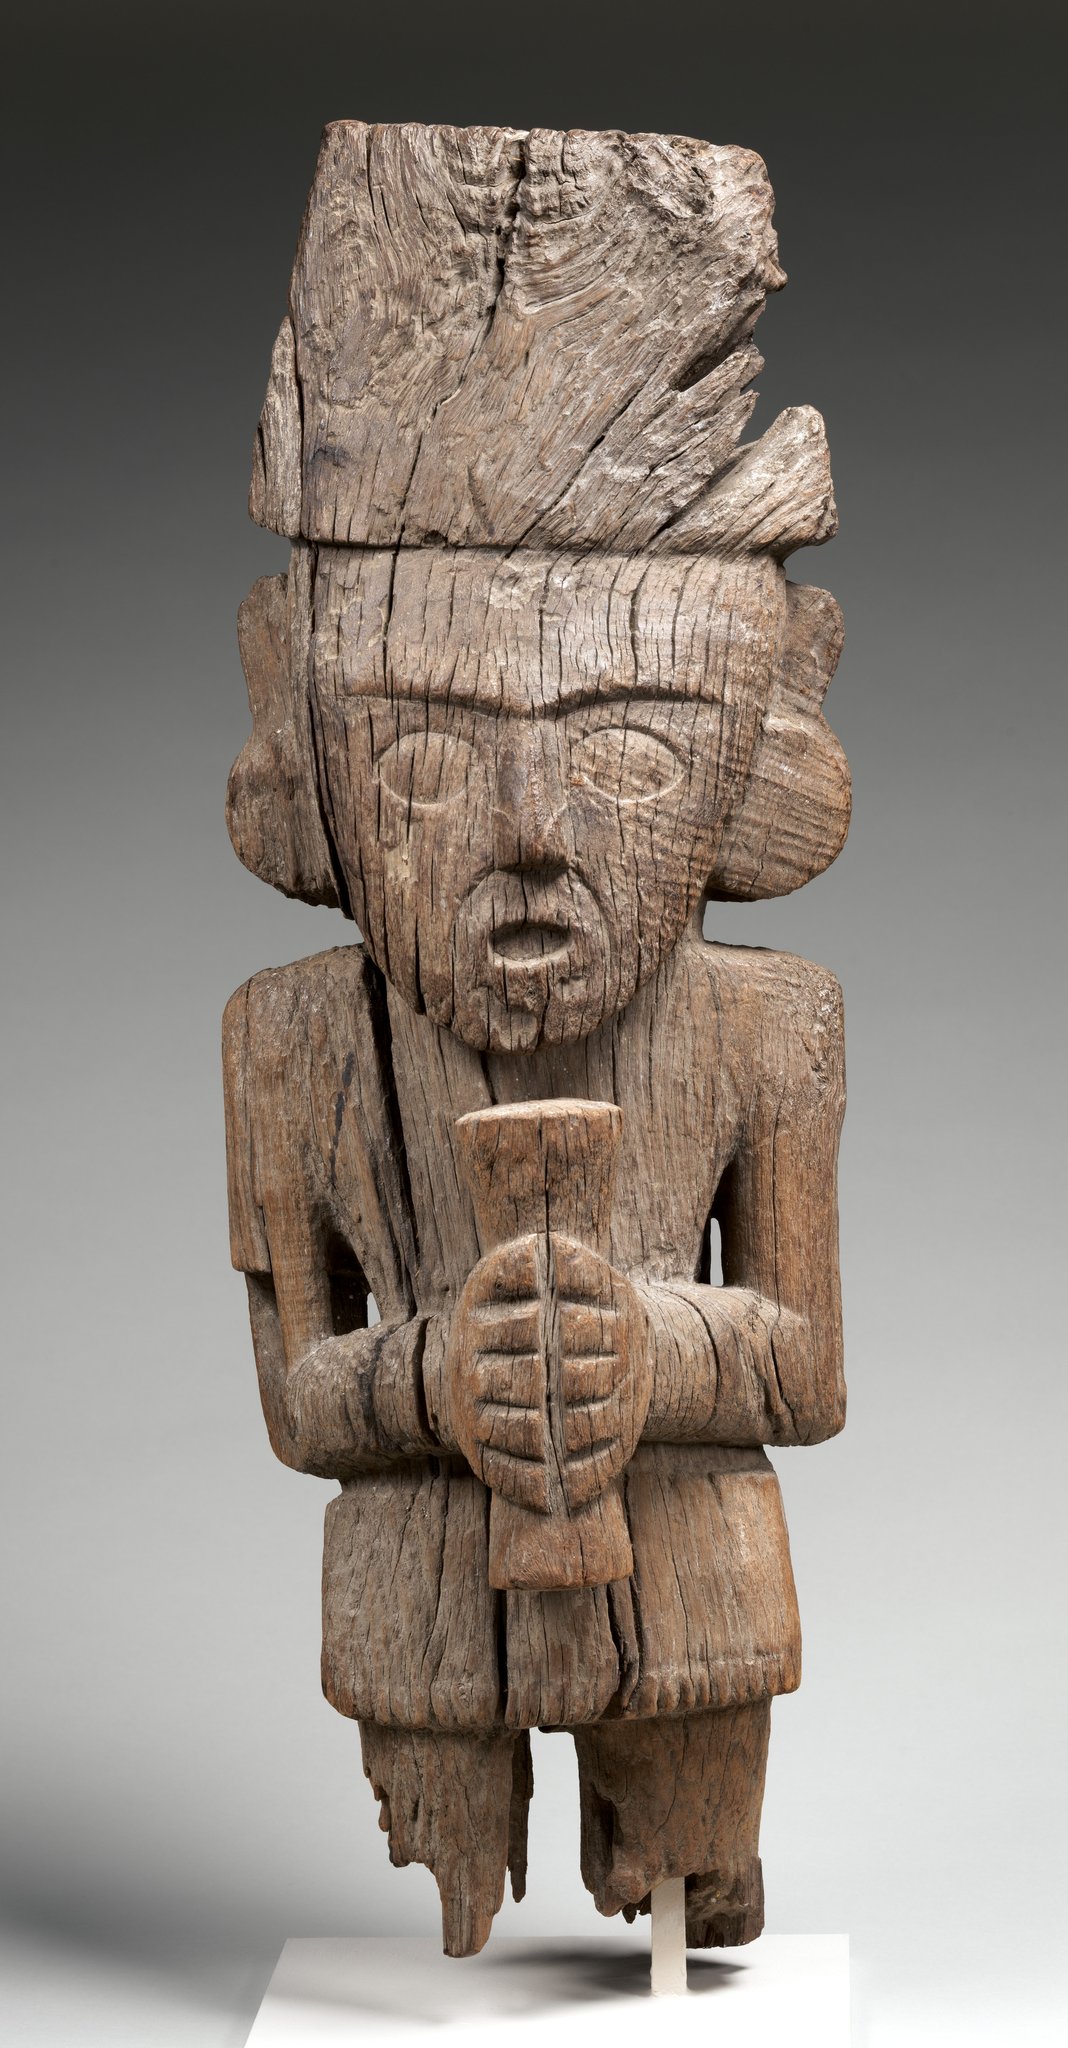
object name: male figure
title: Standing male figure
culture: chimú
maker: chimú artist(s)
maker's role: artist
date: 1300-1470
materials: wood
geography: peru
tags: men